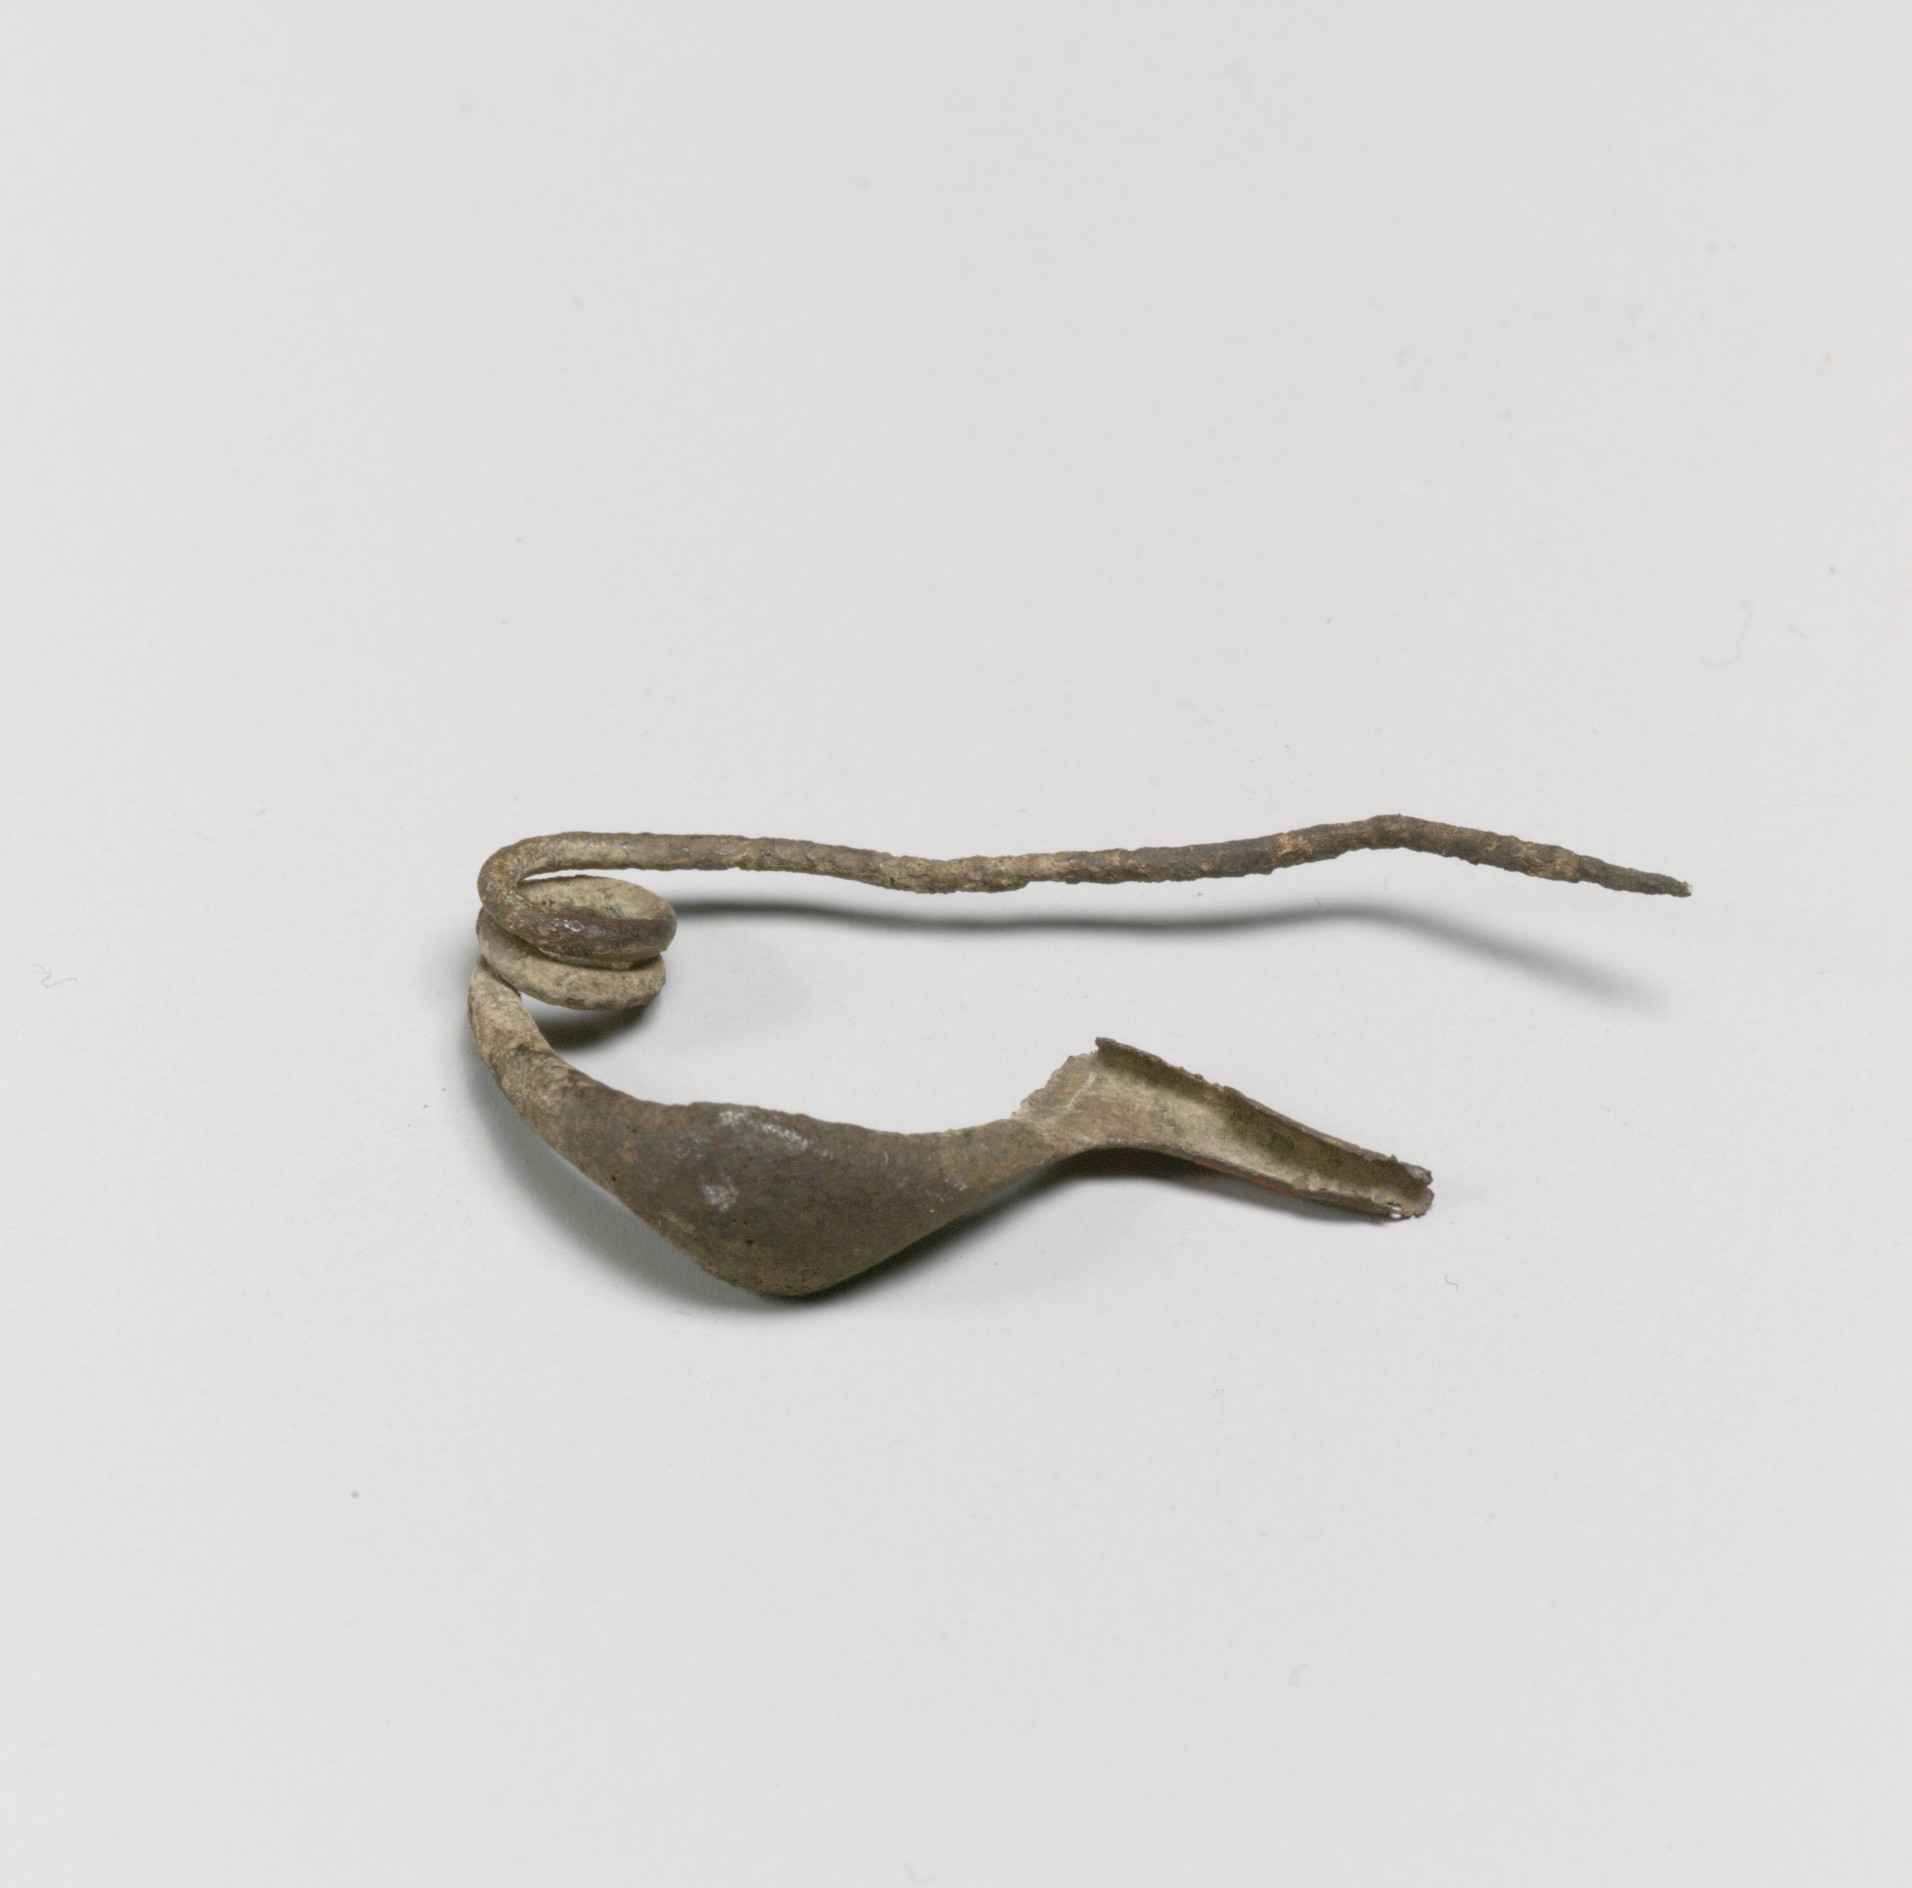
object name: fibula, boat shaped type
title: Fibula, boat-shaped type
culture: italic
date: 800-501 BCE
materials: bronze